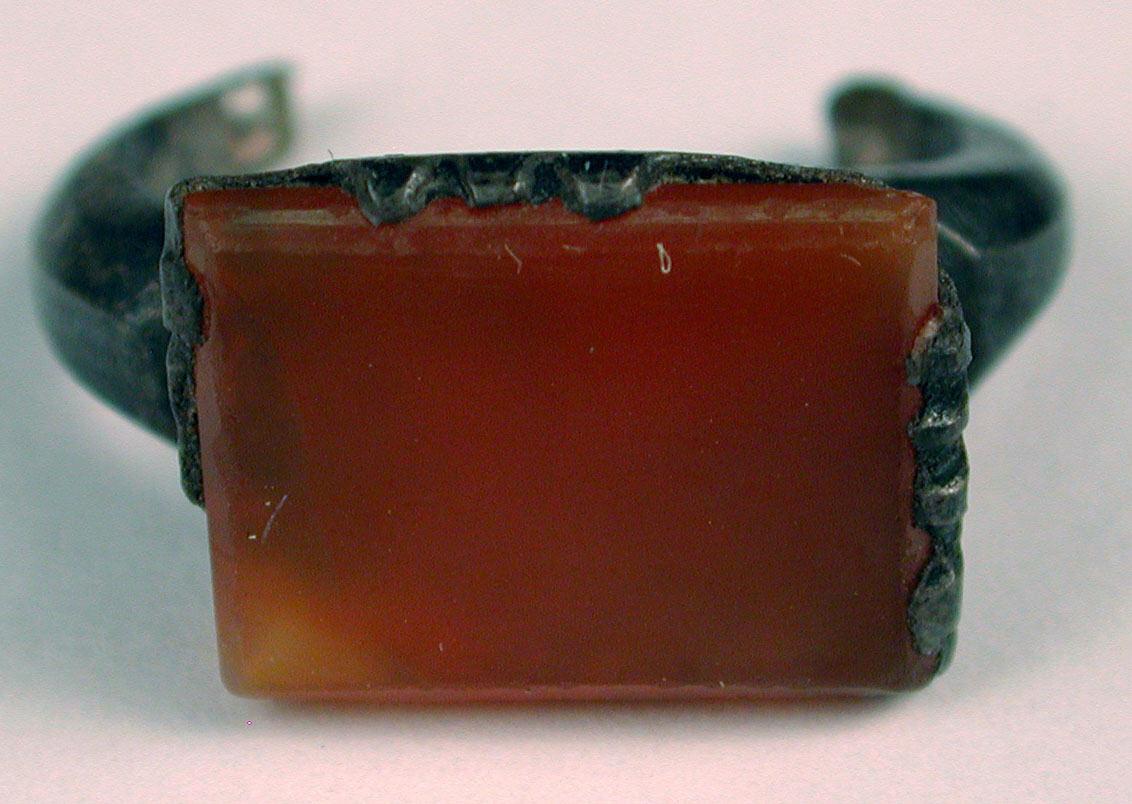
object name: ring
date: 801-1100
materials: gemstone, silver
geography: iran